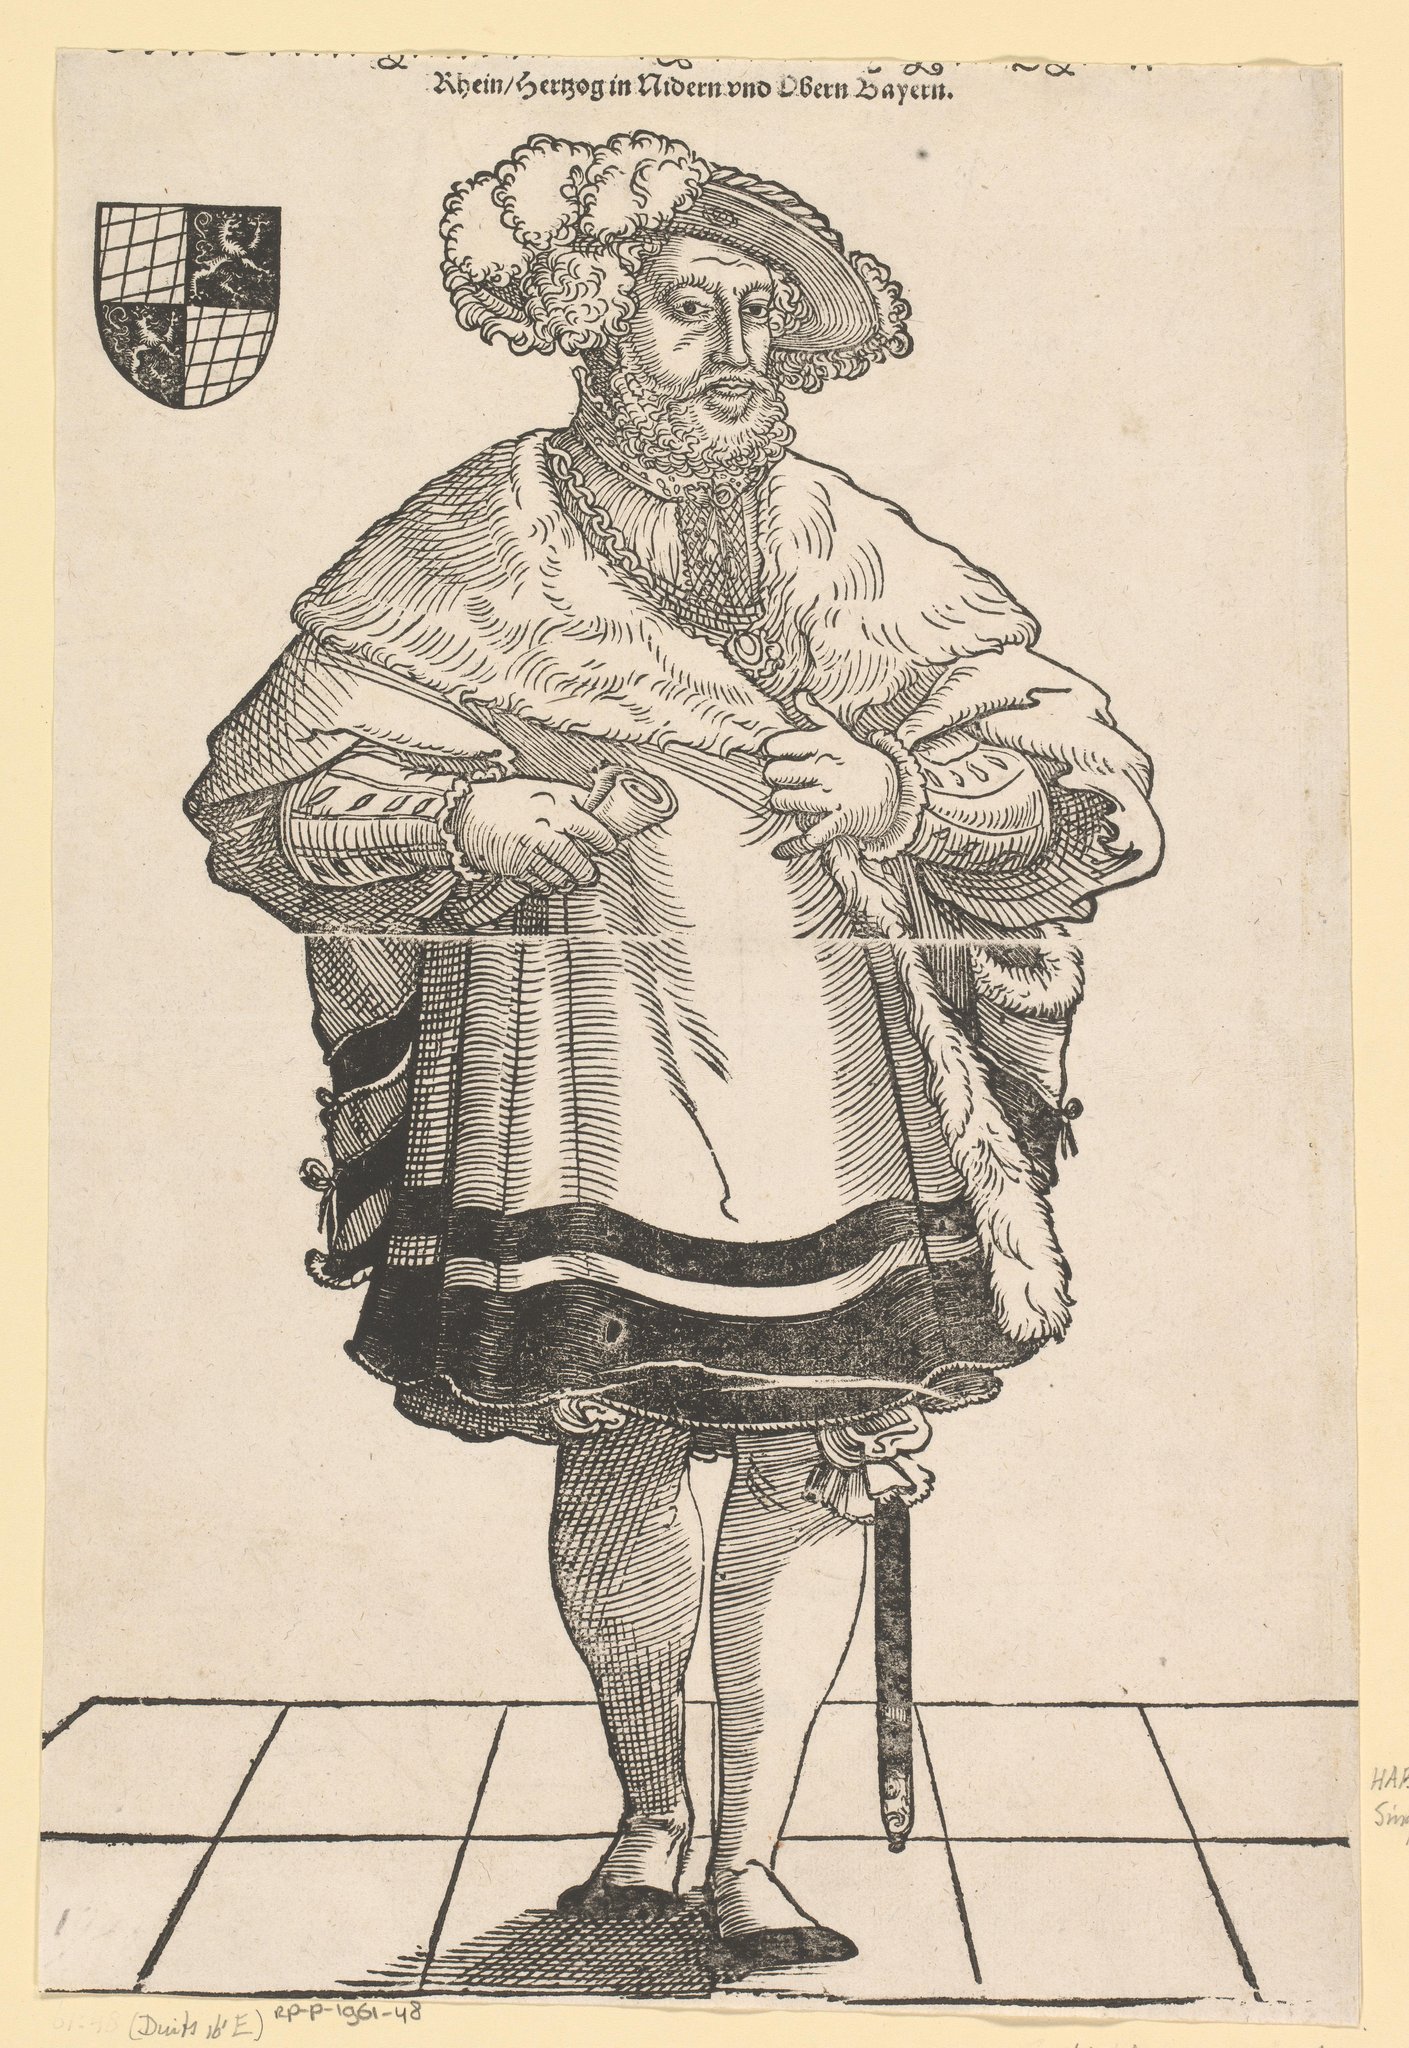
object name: print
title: Portret van Wolfgang van de Palts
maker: Anonymous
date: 1524-1599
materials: paper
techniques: woodcut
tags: coat of arms (symbol of sovereignty), historical persons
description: Met gedeeltelijk afgesneden bovenschrift in het Duits.